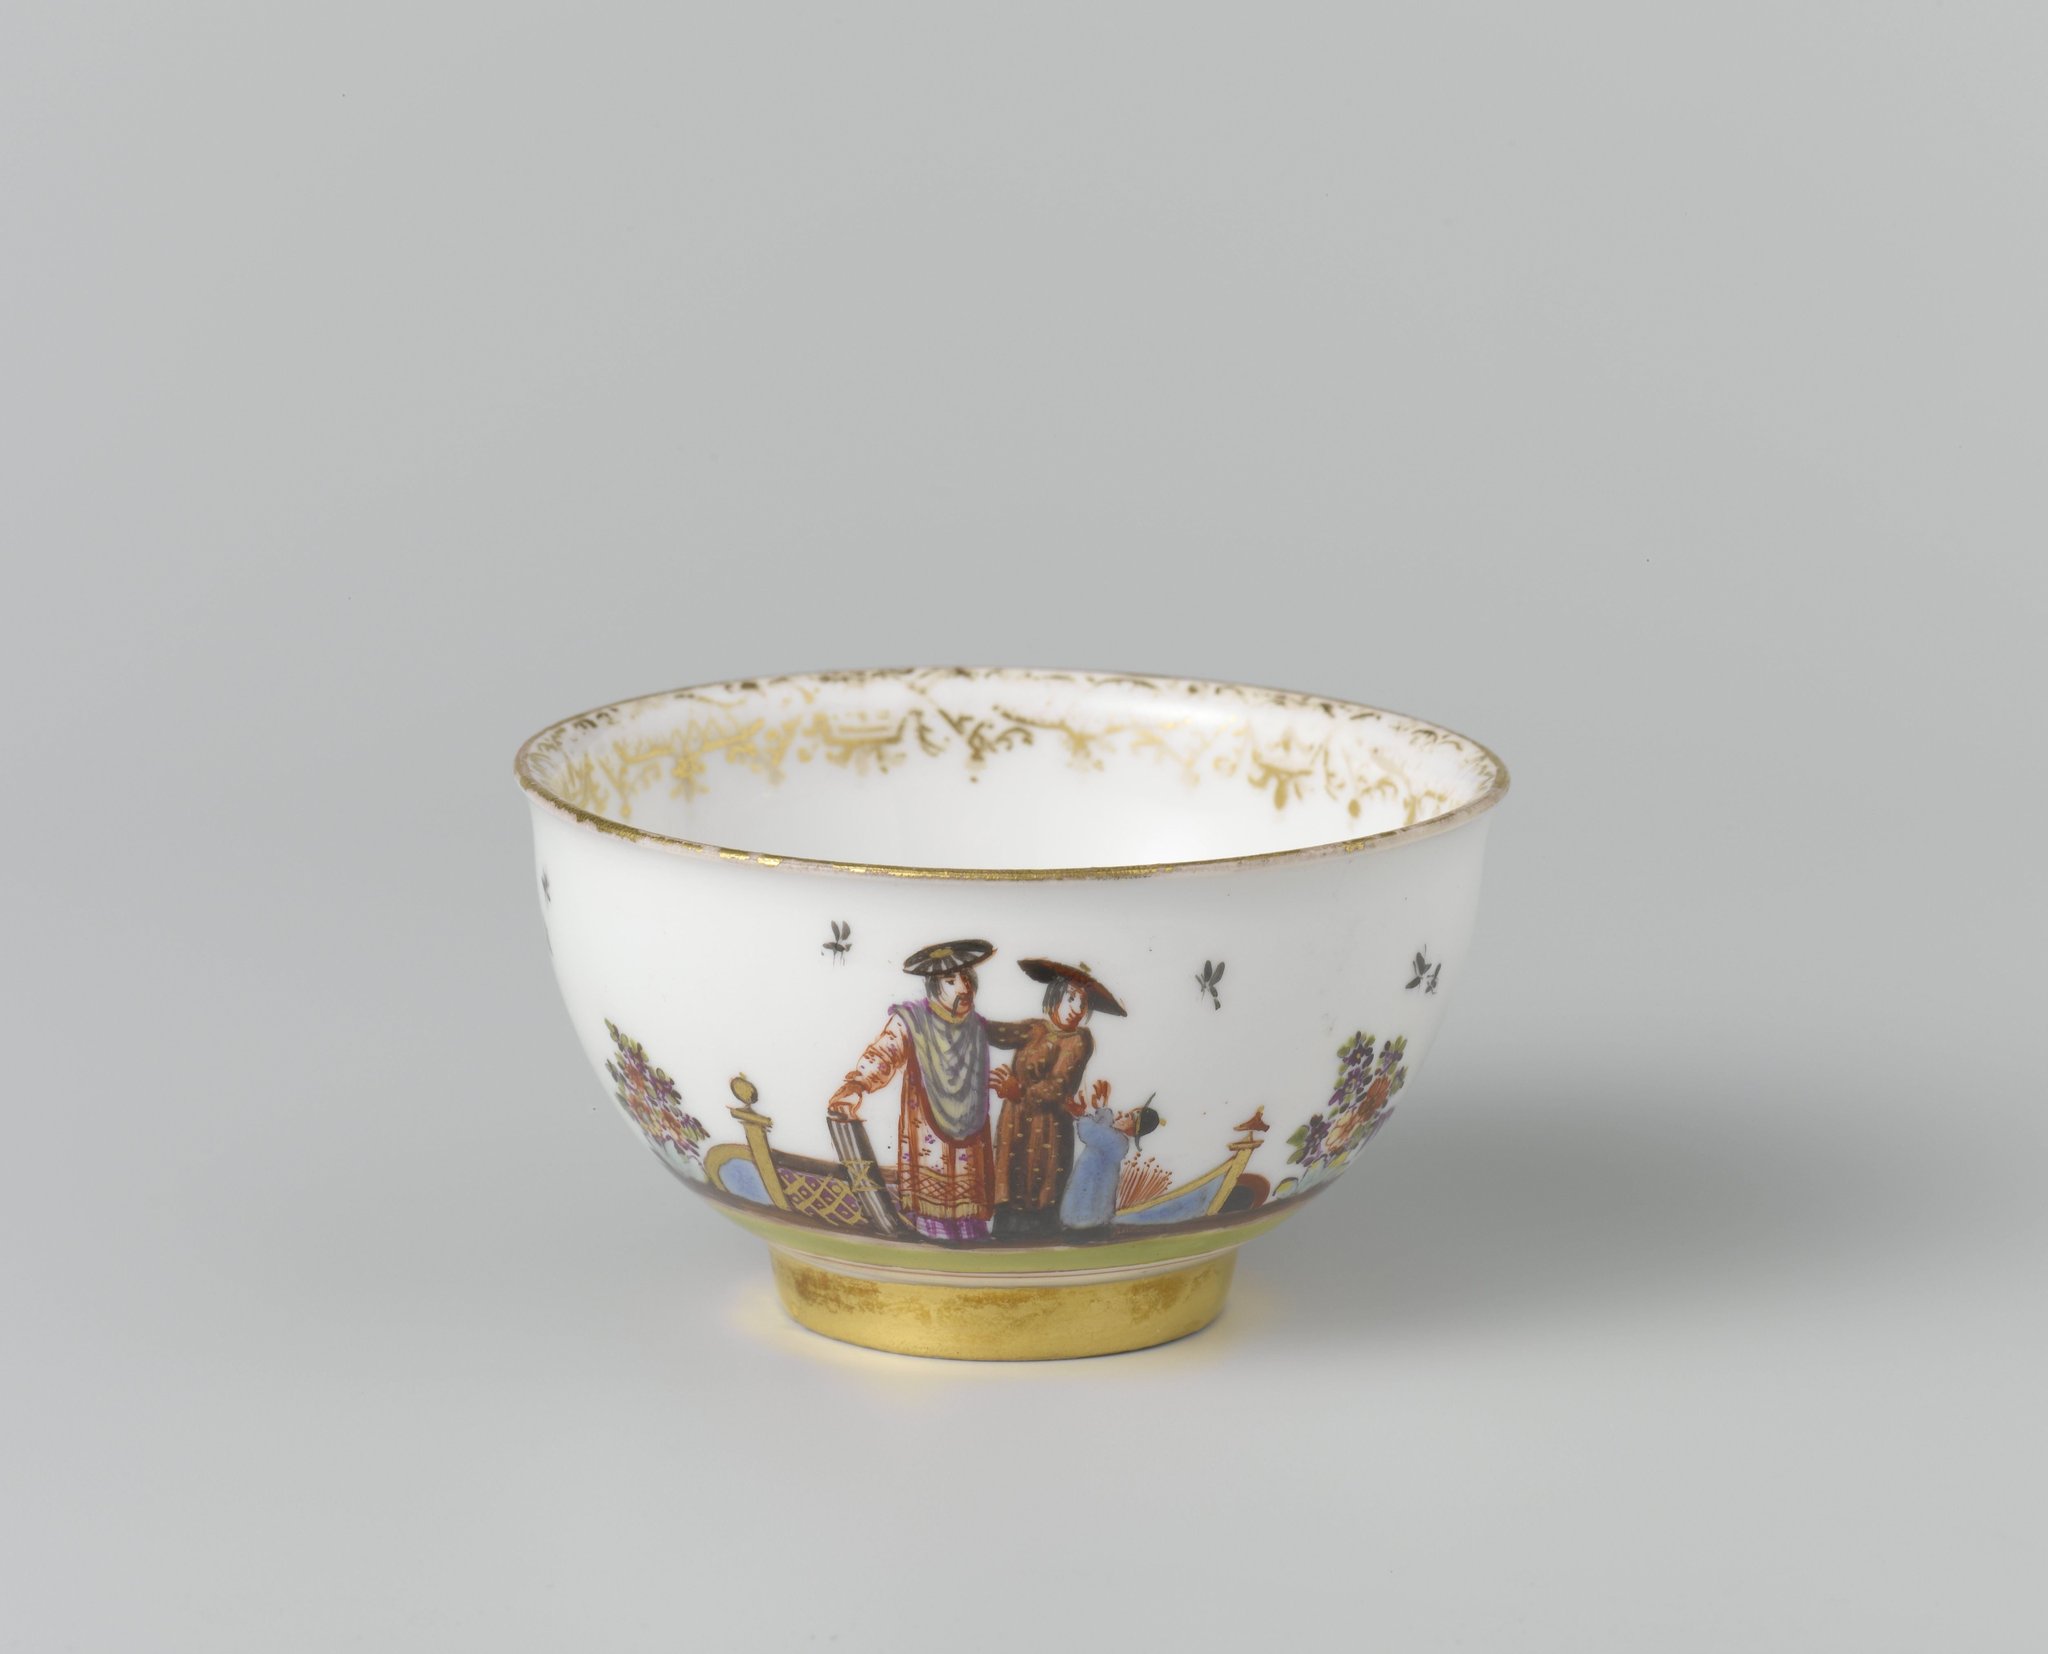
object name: cup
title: Cup and saucer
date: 1730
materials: porcelain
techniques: painted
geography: meissen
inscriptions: mold mark, factory mark, mark: ‘13.’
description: Meissener Porzellan Manufaktur Meissen, c. 1730 hard-paste porcelain